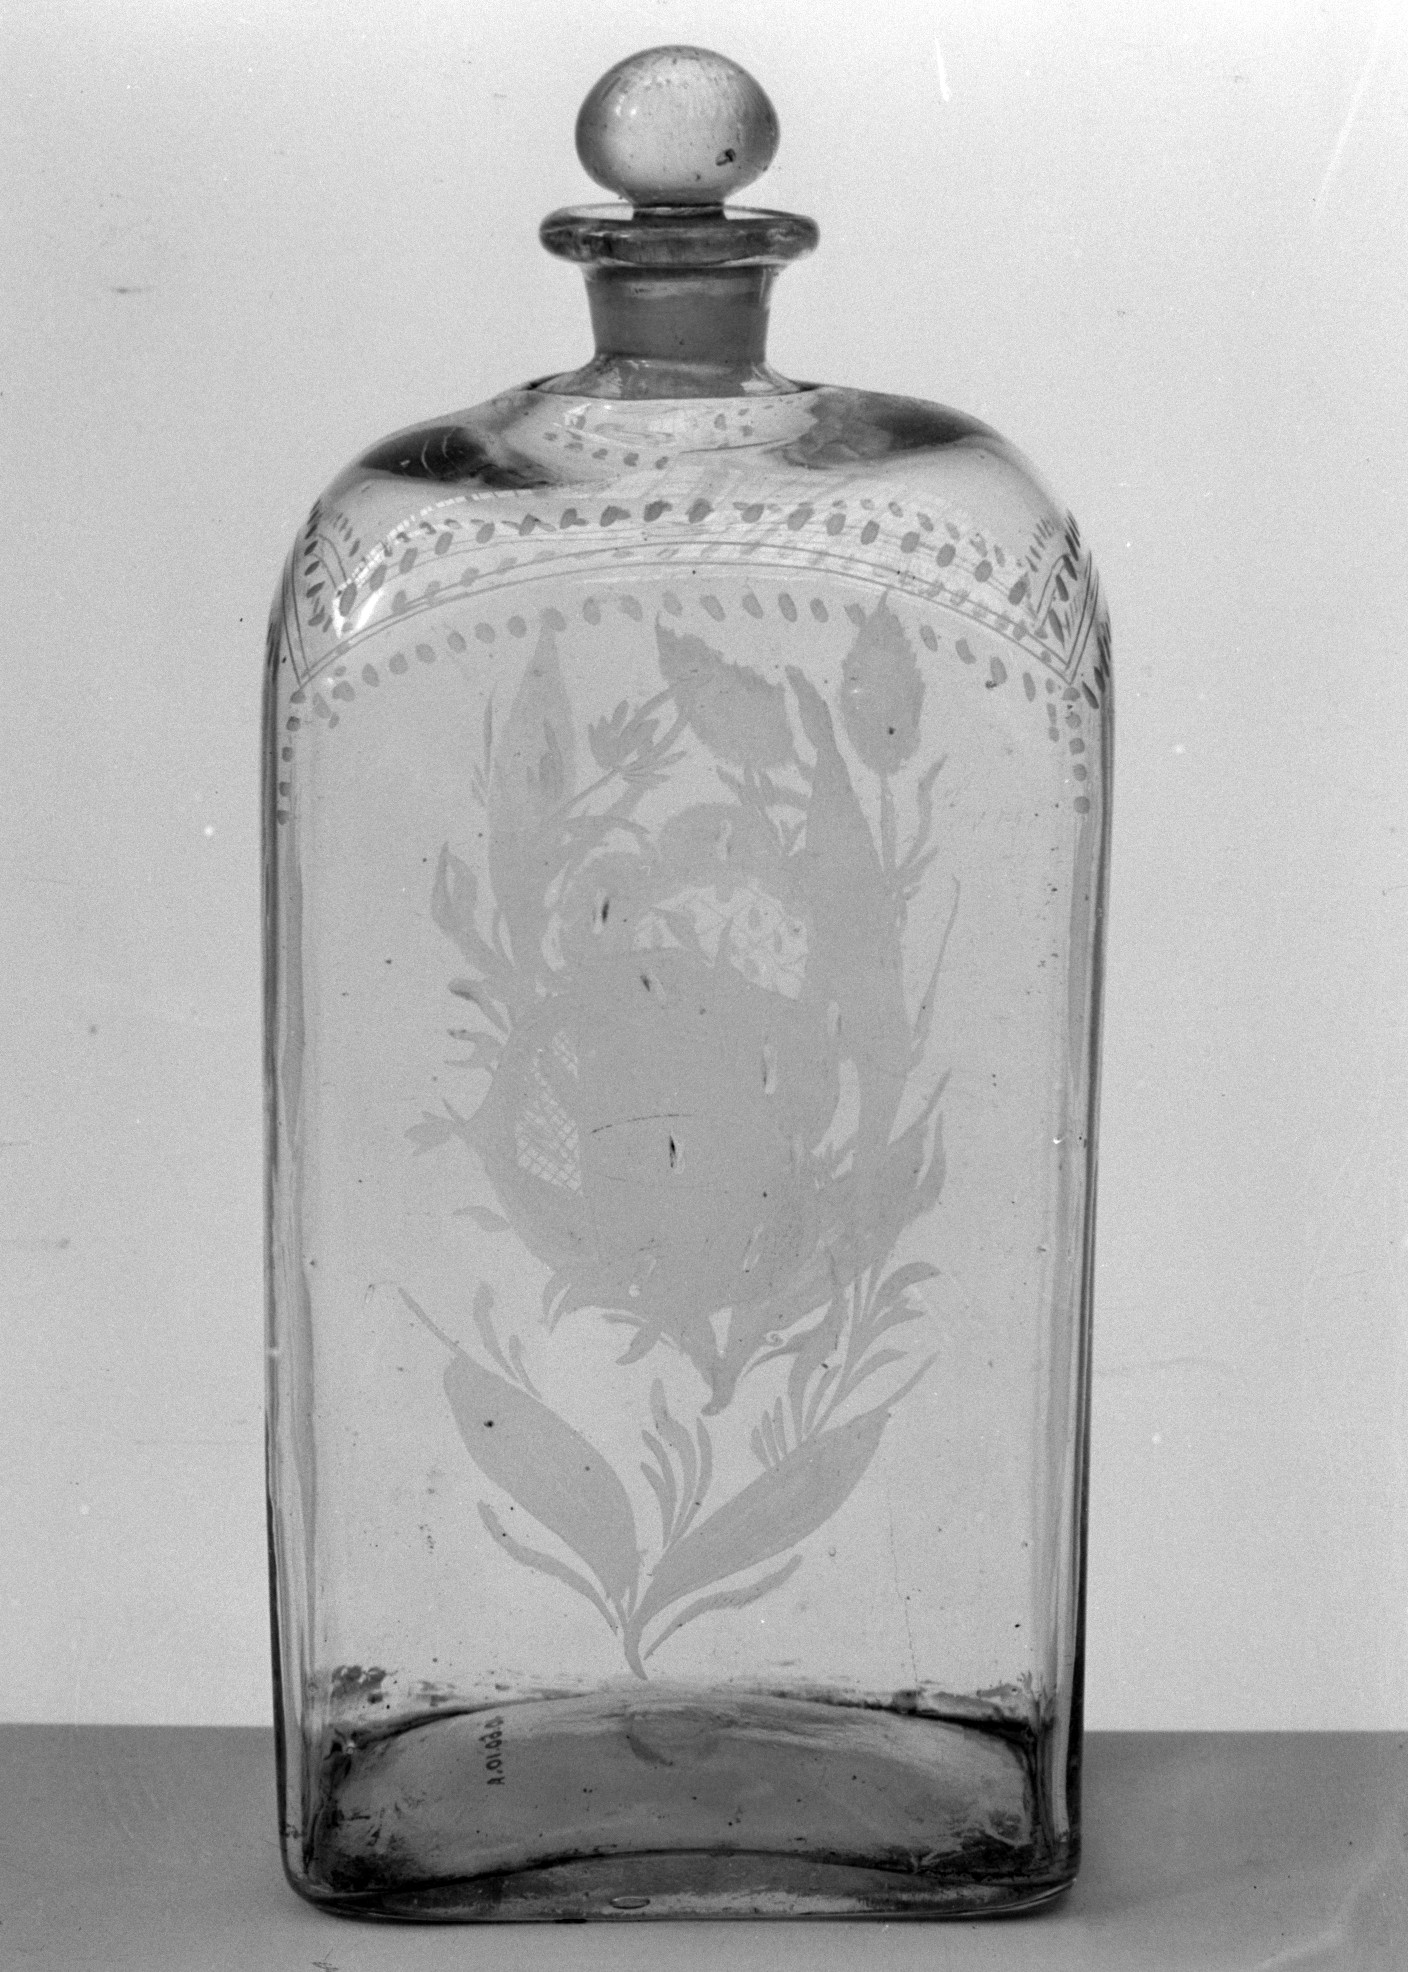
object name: bottle with stopper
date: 1751-1800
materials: glass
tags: flowers